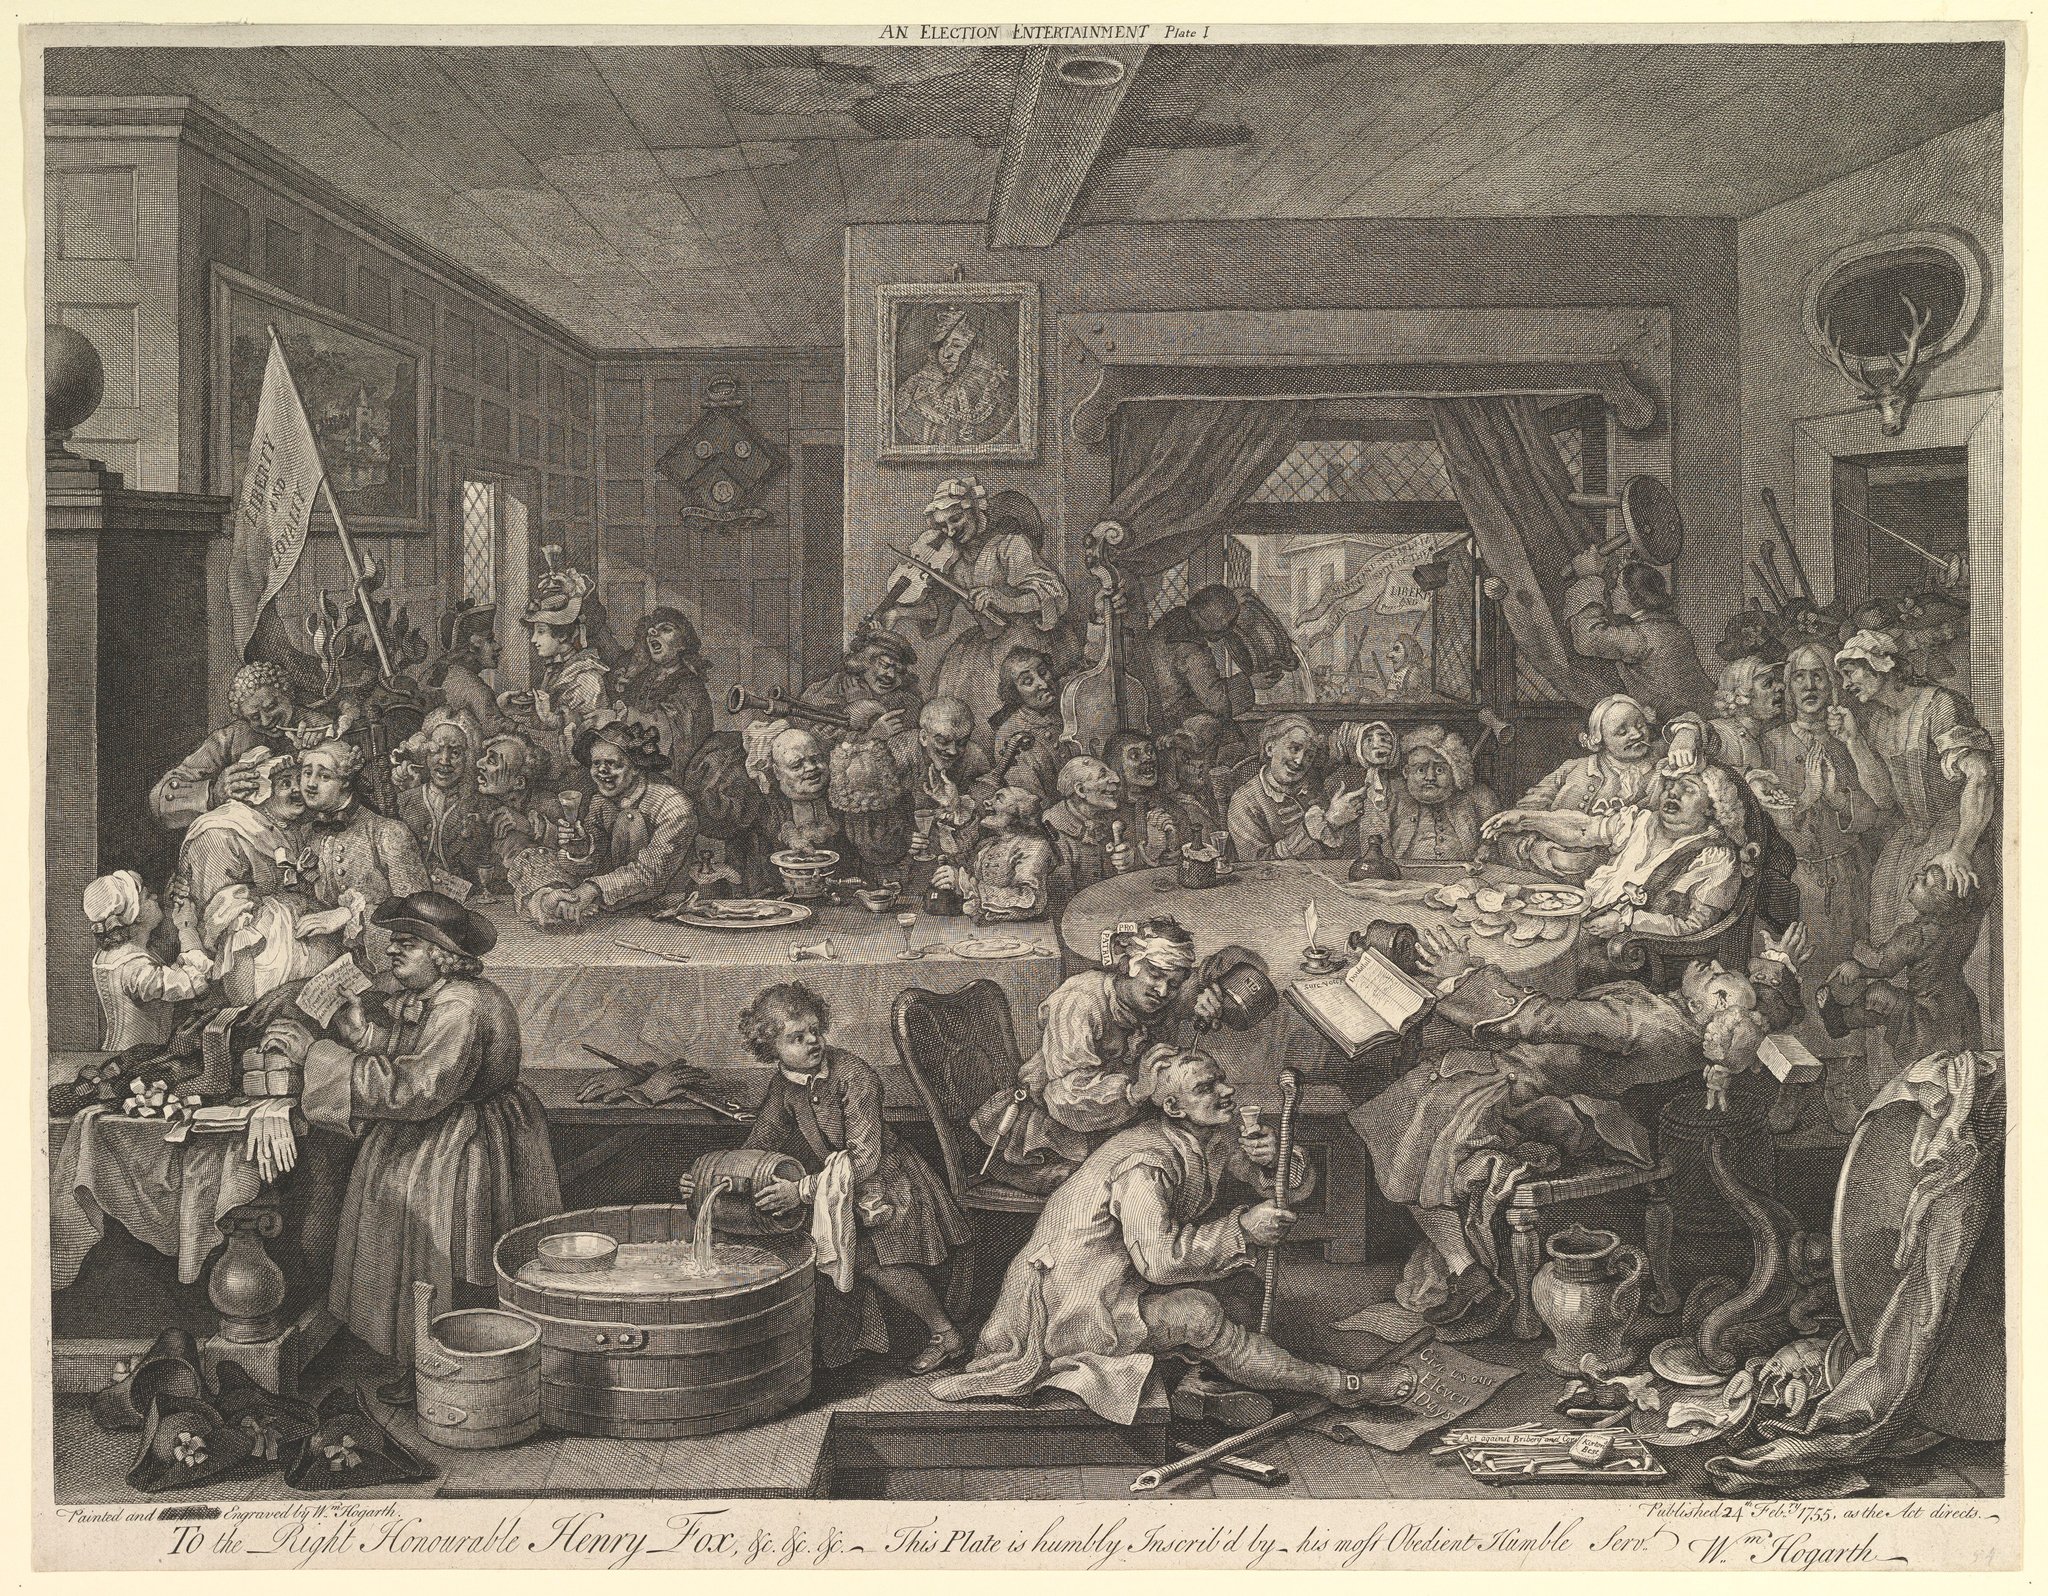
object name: print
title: An Election Entertainment, Plate I: Four Prints of an Election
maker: william hogarth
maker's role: artist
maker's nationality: british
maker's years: 1697-1764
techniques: engraving, etching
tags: satire,children,men,women,party,drinking,musicians